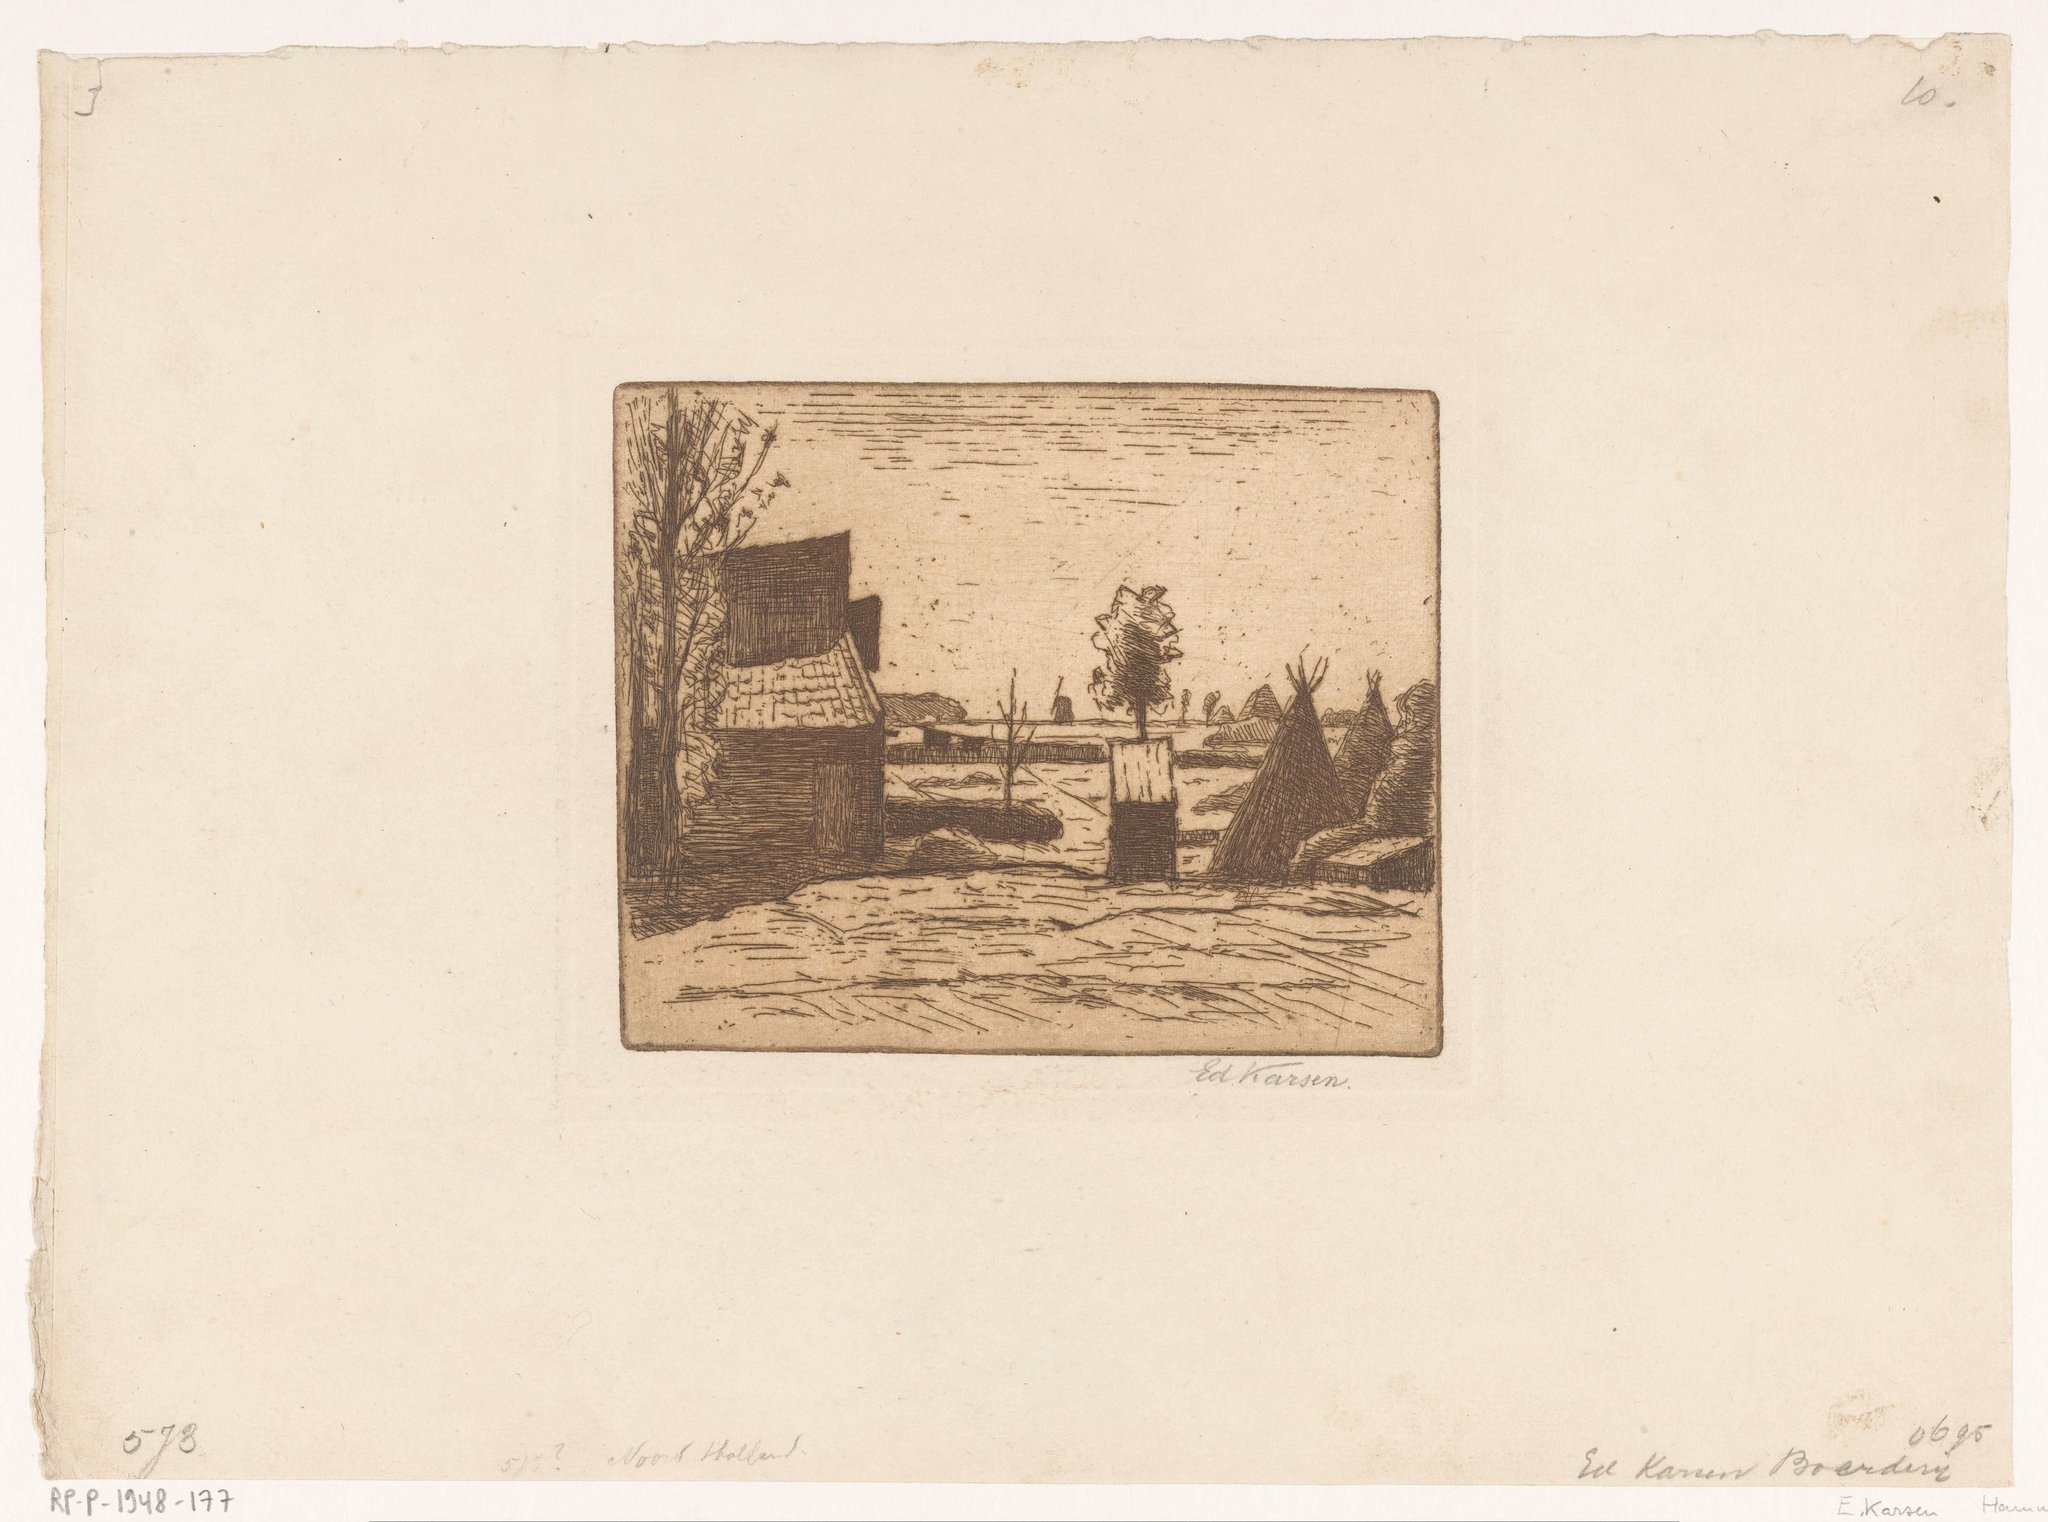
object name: print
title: Boerderij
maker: eduard karsen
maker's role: draughtsman, painter, print maker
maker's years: 1860-1941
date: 1870-1941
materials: paper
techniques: etching, intaglio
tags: barn, hay-stack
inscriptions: collector's mark: Lugt 2228, inscription: ‘Noord-Holland’